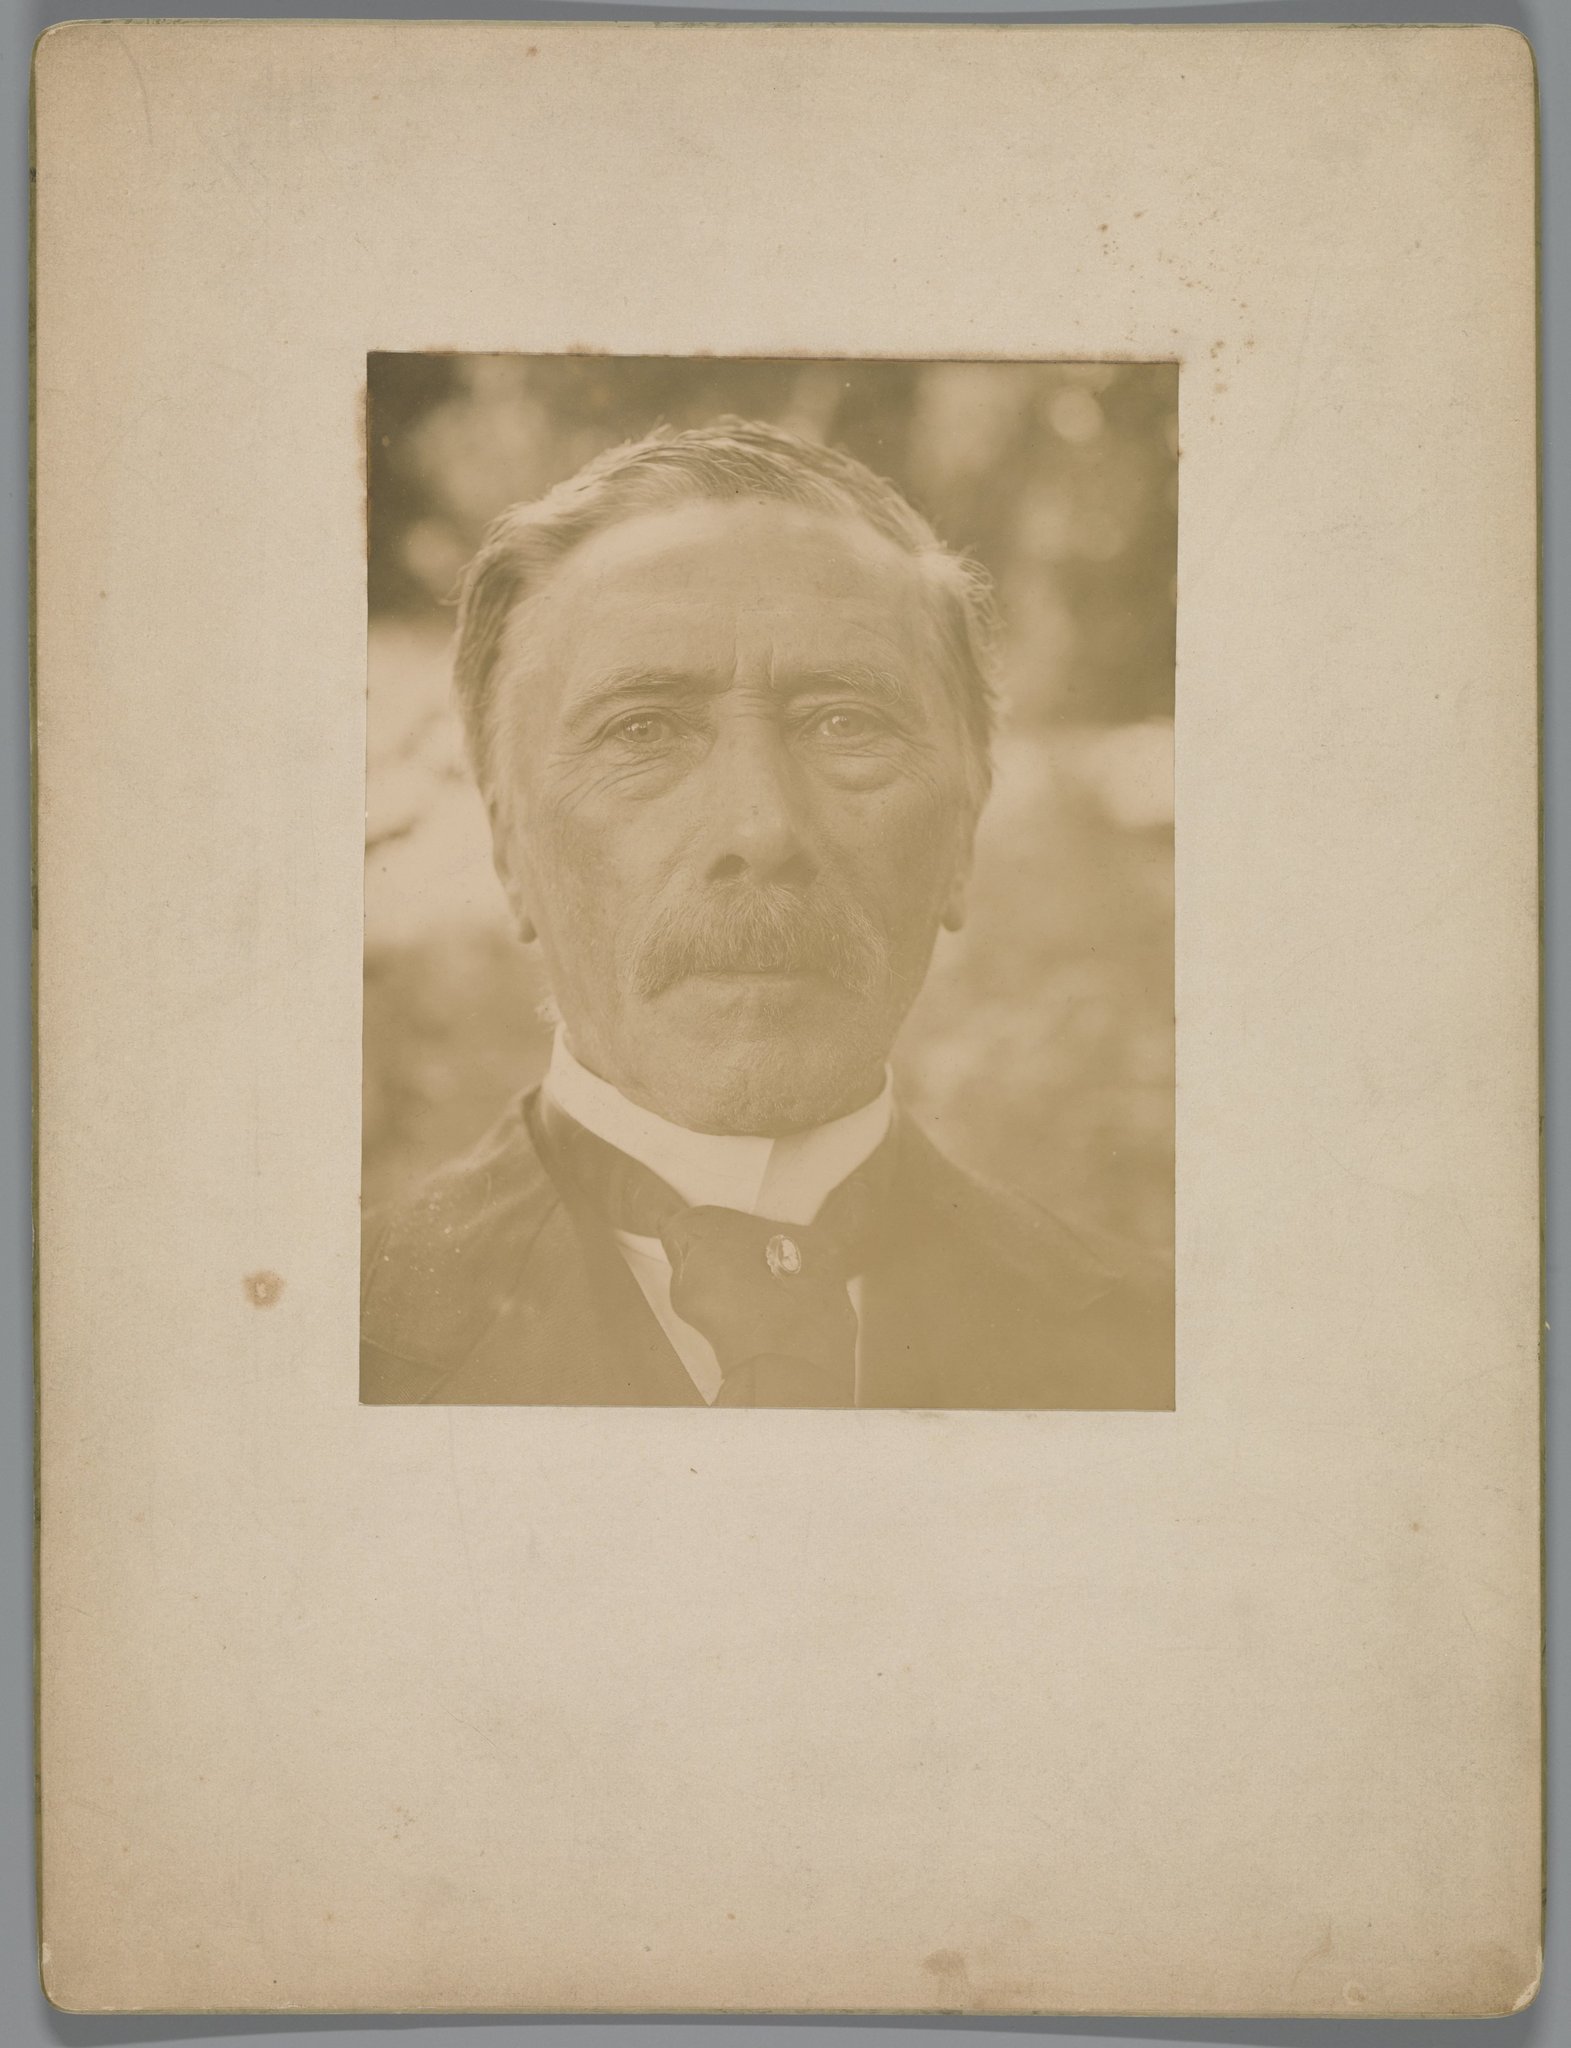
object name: photograph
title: J.J. Witsen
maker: willem witsen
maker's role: draughtsman, painter, print maker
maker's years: 1860-1923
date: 1860-1915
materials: cardboard, paper, photographic support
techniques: gelatin silver print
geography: amsterdam